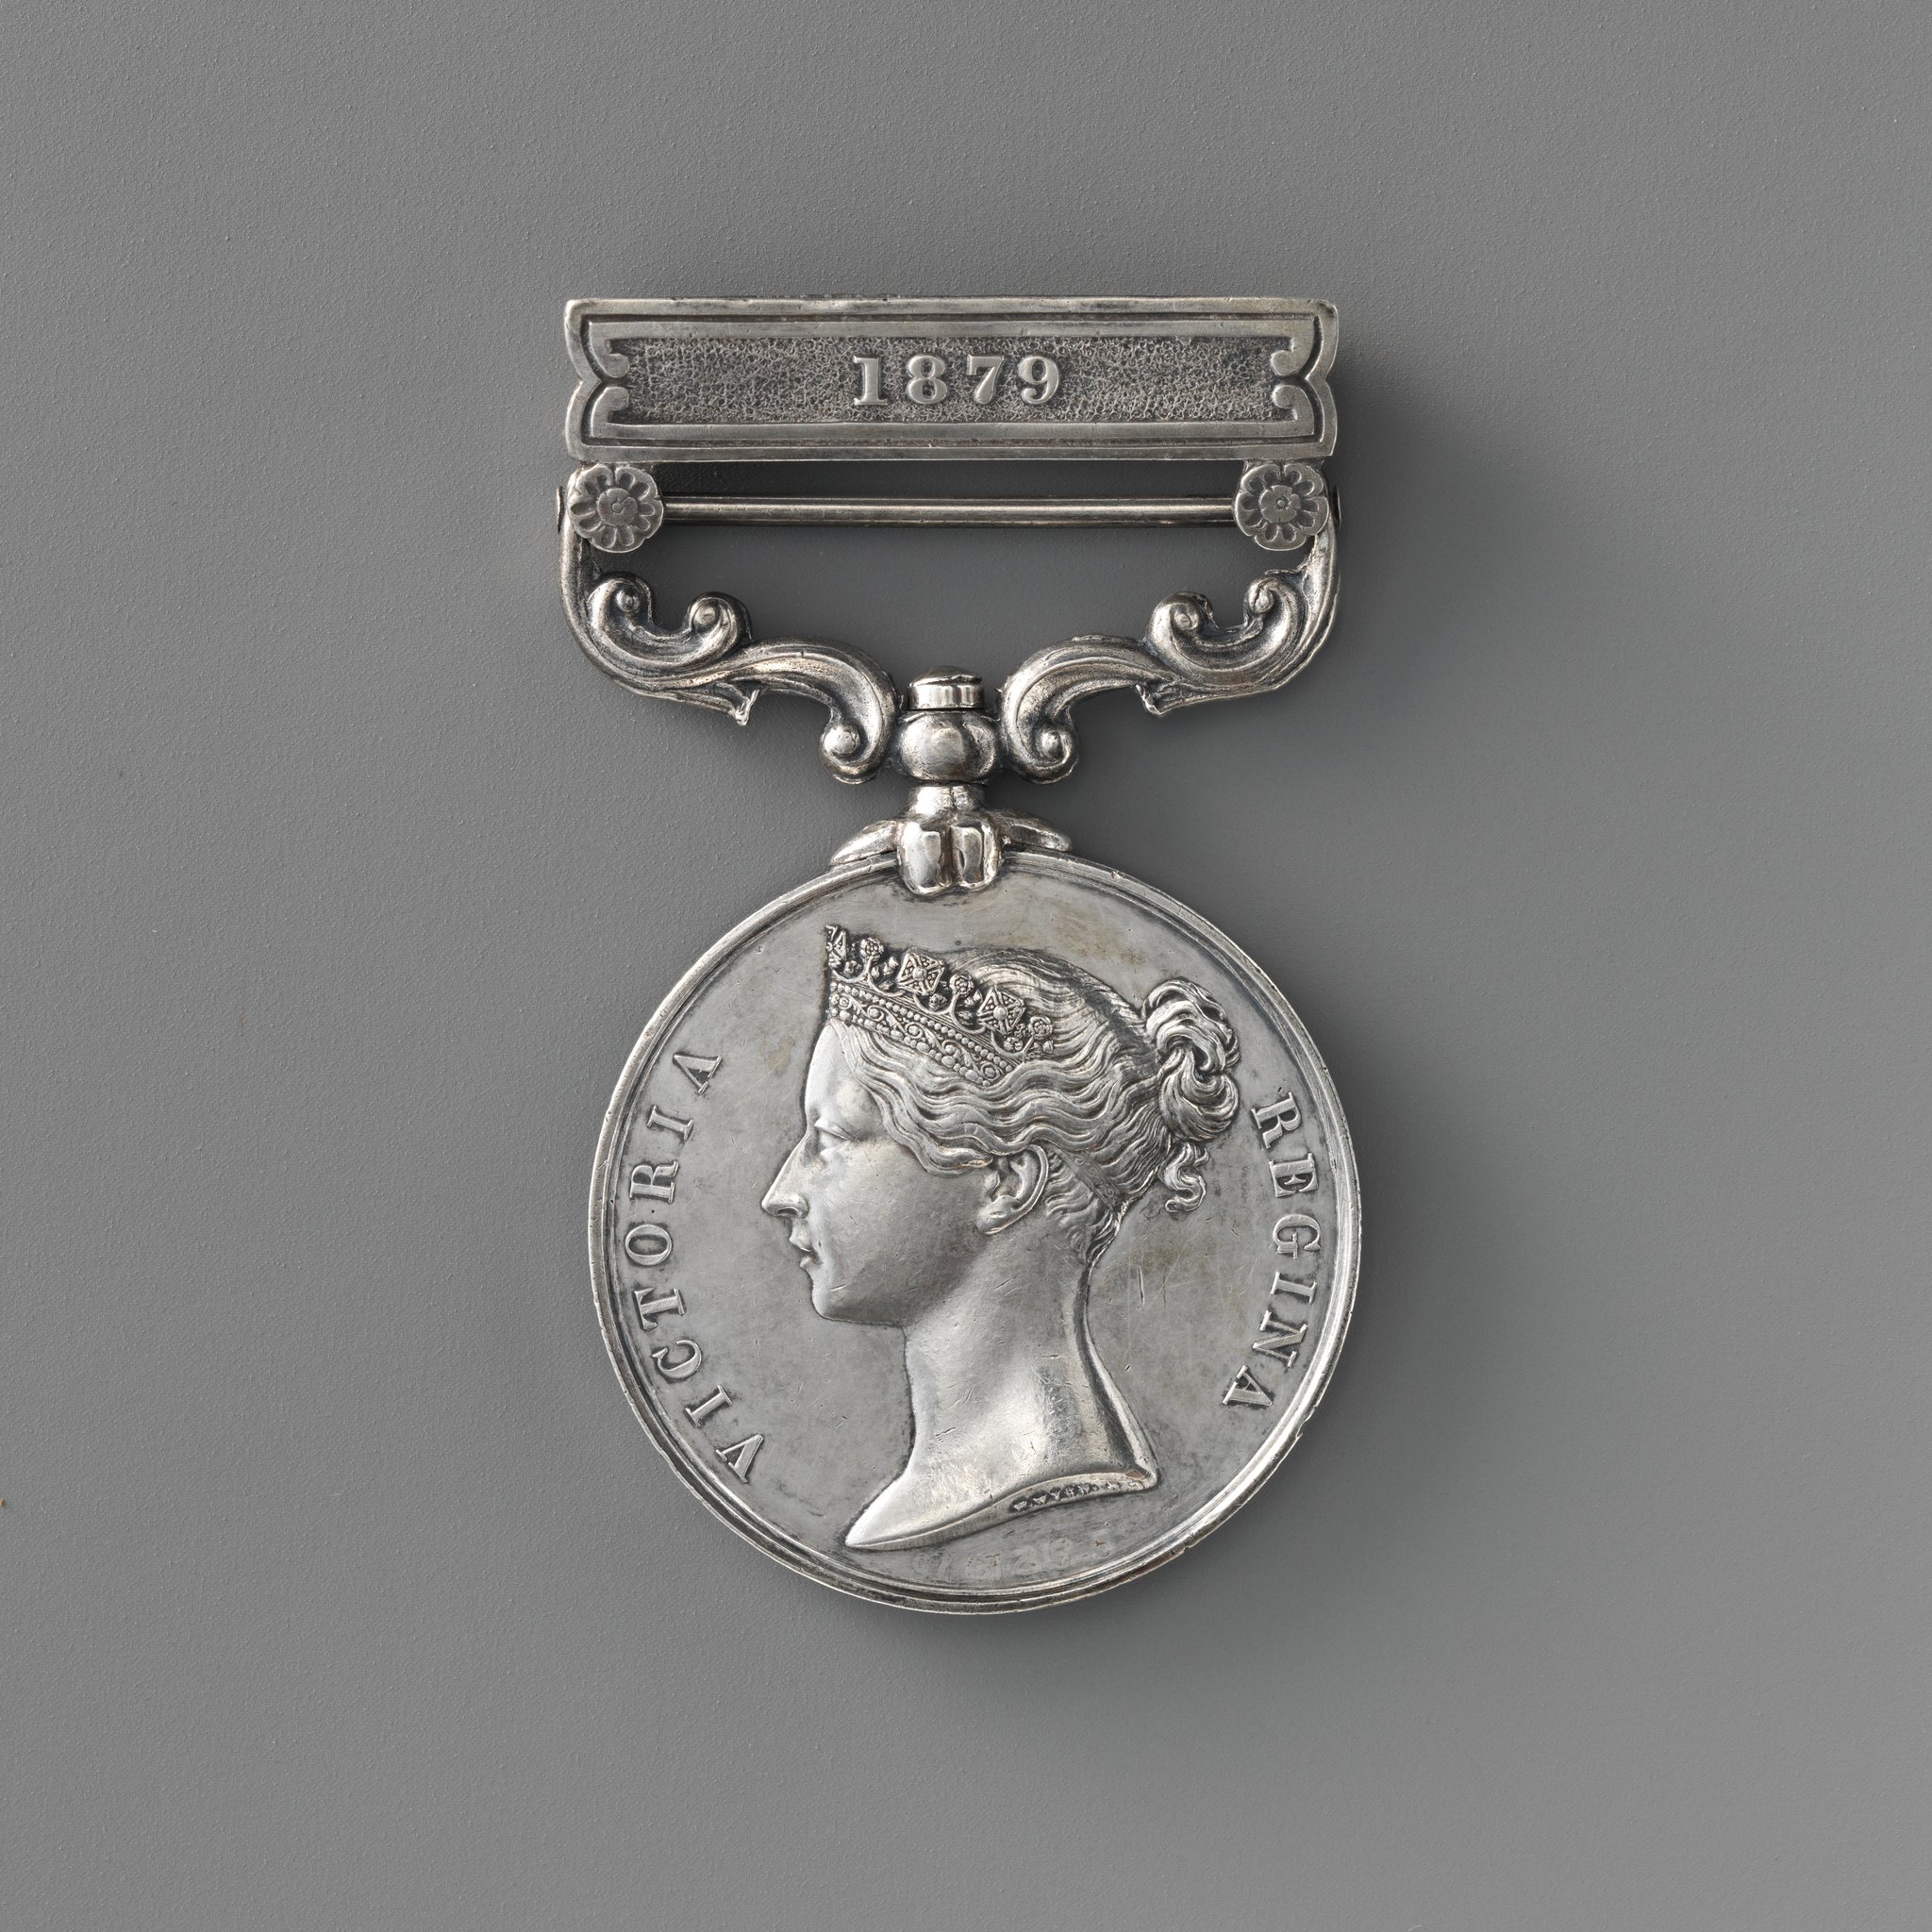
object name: medal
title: The South African Medal, Issued for the Campaigns of 1877–79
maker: william wyon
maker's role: artist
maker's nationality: british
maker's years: 1795-1851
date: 1879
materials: silver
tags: profiles,women